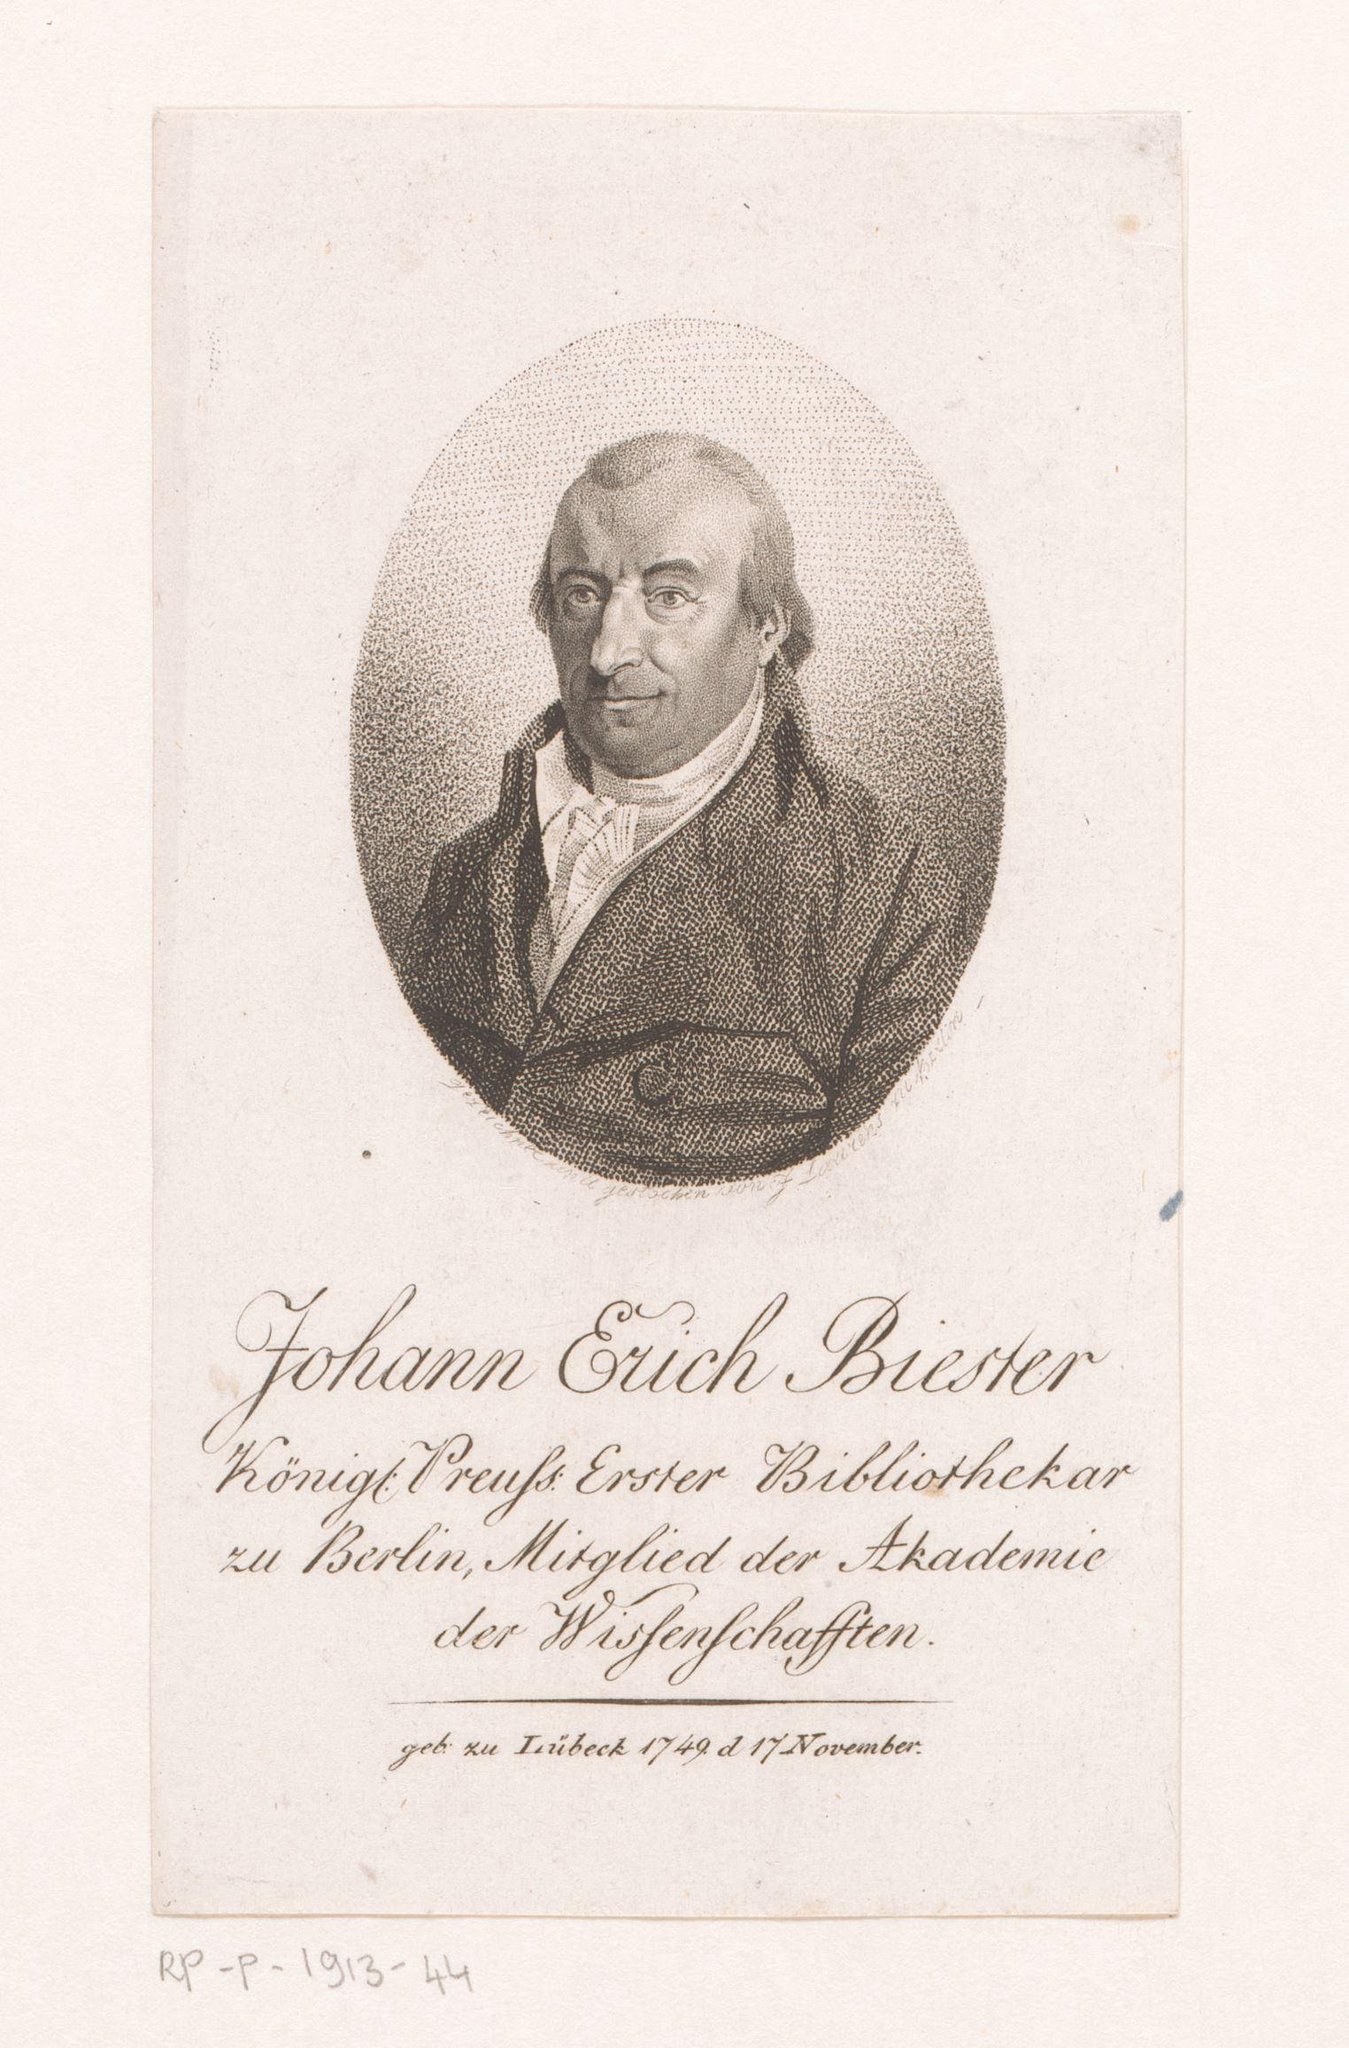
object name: print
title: Portret van Johann Erich Biester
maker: johann daniel laurenz (ii)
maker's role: draughtsman, print maker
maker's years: 1770-1832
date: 1780-1832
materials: paper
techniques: etching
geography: berlin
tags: berlin, publishing, publisher (+ portrait of scholar, scientist), historical persons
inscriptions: collector's mark: Lugt 2228